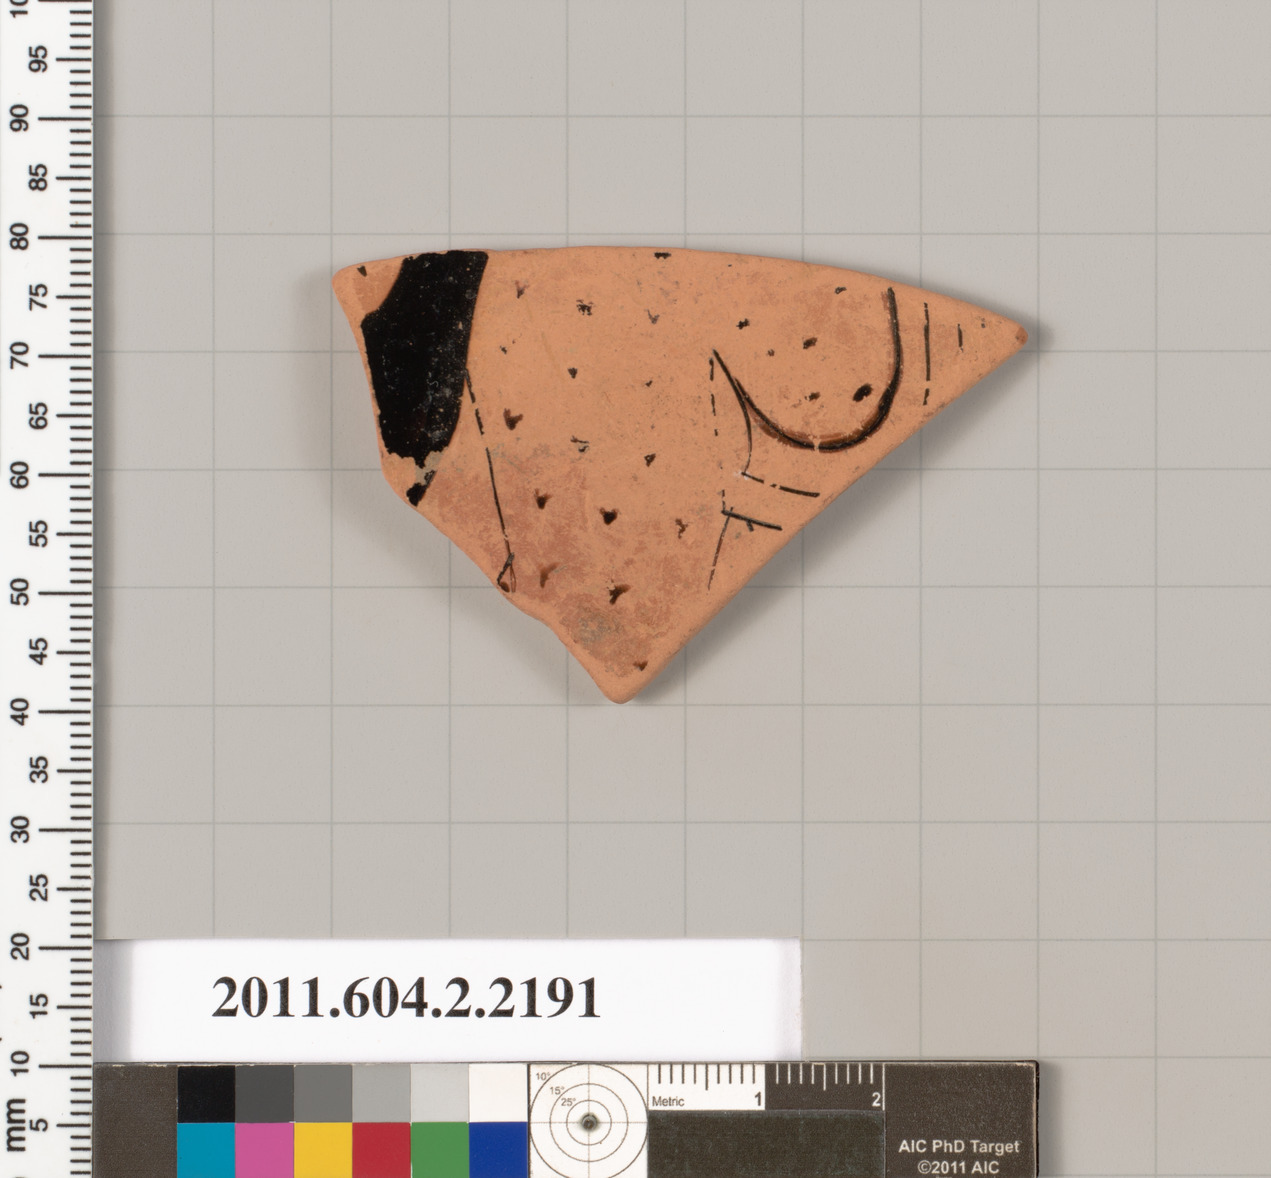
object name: pot fragment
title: Terracotta fragment of a pot; unglazed on the inside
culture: greek, attic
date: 460-440 BCE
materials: terracotta